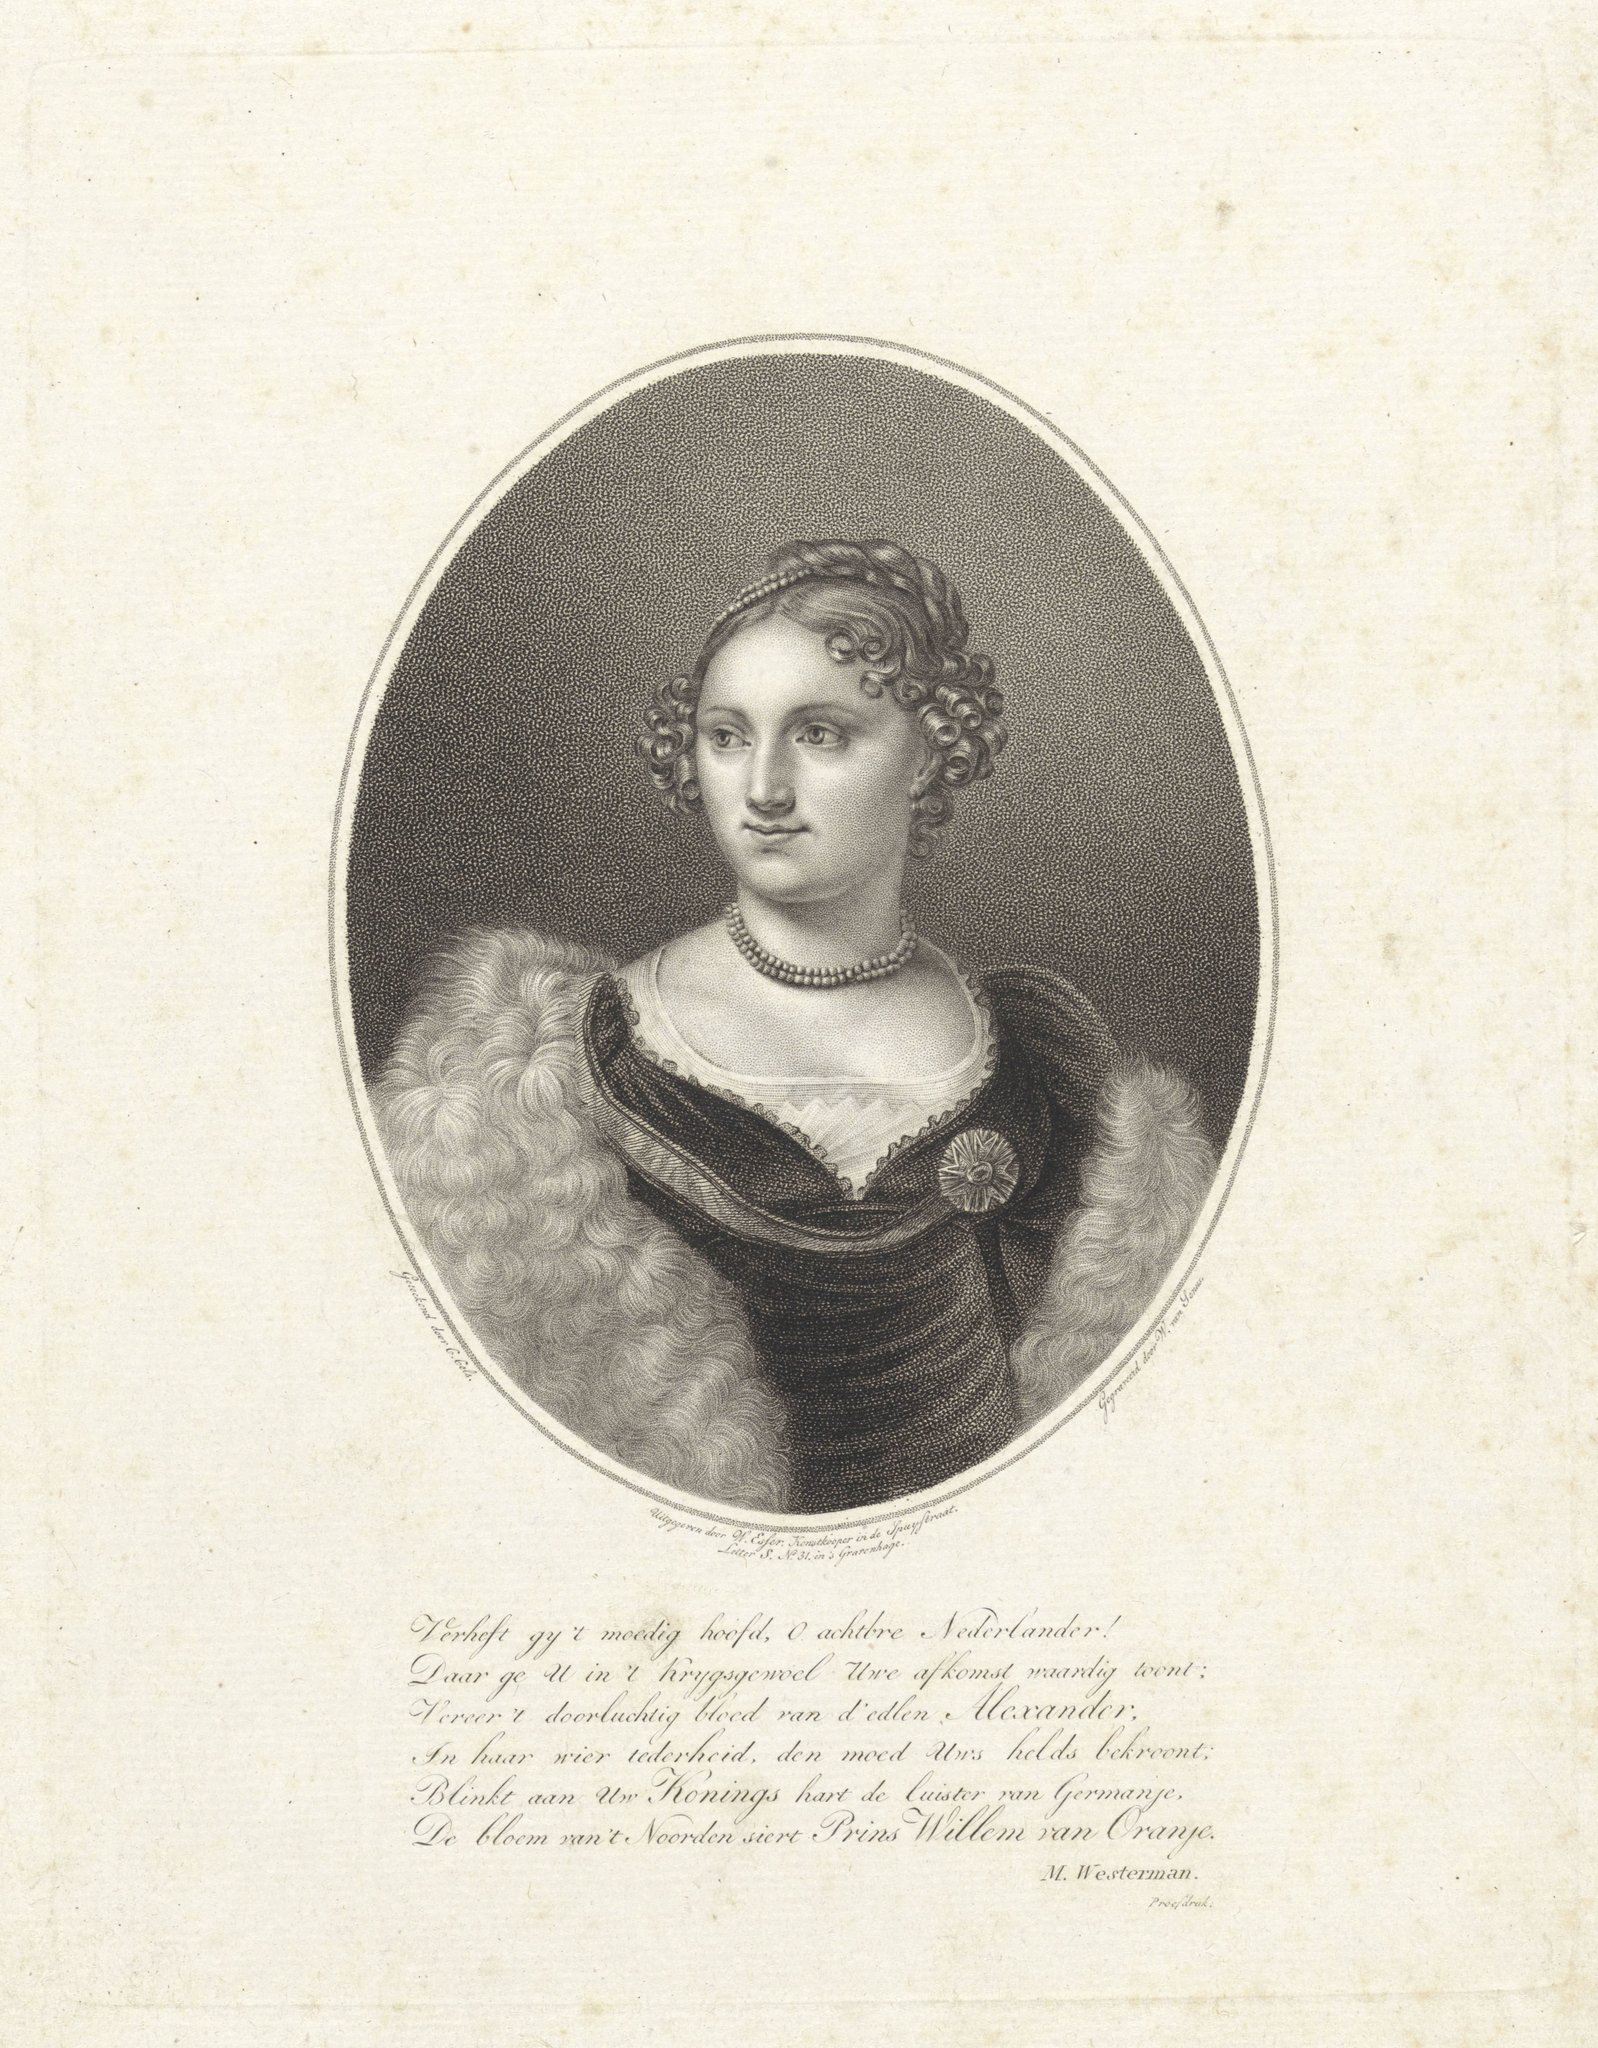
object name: print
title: Portret van Anna Paulowna Romanowa (koningin der Nederlanden)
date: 1816-1840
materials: paper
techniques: engraving, etching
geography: the hague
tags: the hague, anna paulowna romanowa, coat (+ fur used for clothes), pearl; pearl necklace (+ women's clothes)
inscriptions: collector's mark: Lugt 2228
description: Portret van Anna Paulowna Romanowa (koningin der Nederlanden), met parelsnoer en bontmantel.